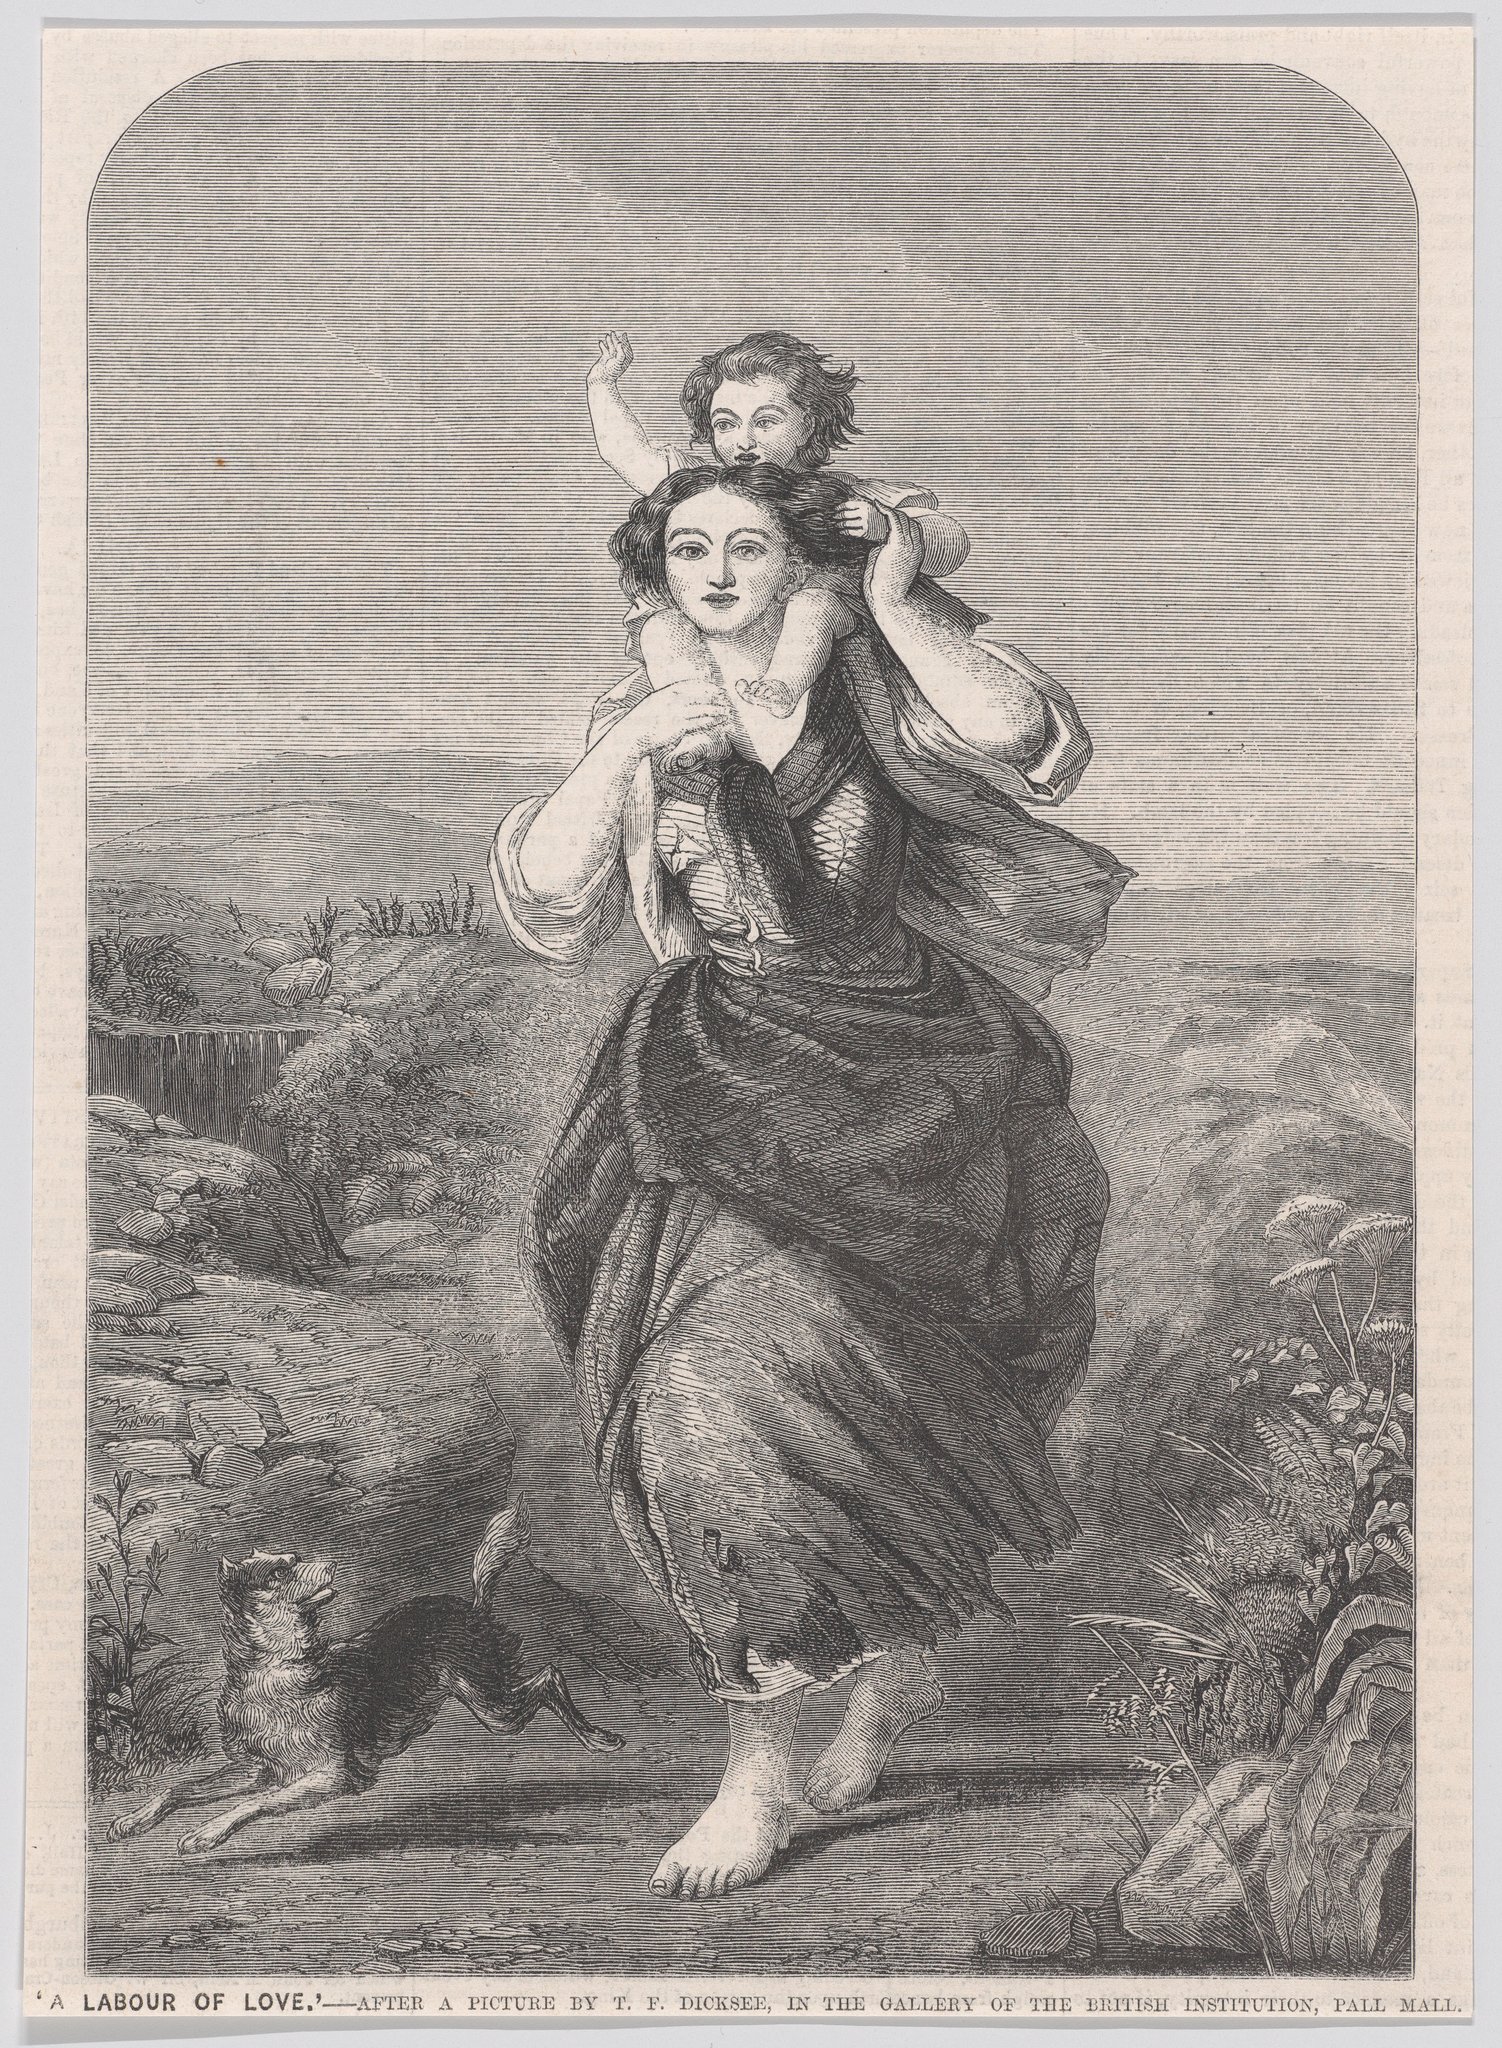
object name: print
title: A Labour of Love, from "Illustrated News of the World"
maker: thomas francis dicksee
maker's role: artist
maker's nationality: british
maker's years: 1819-1895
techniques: engraving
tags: children,women,dogs